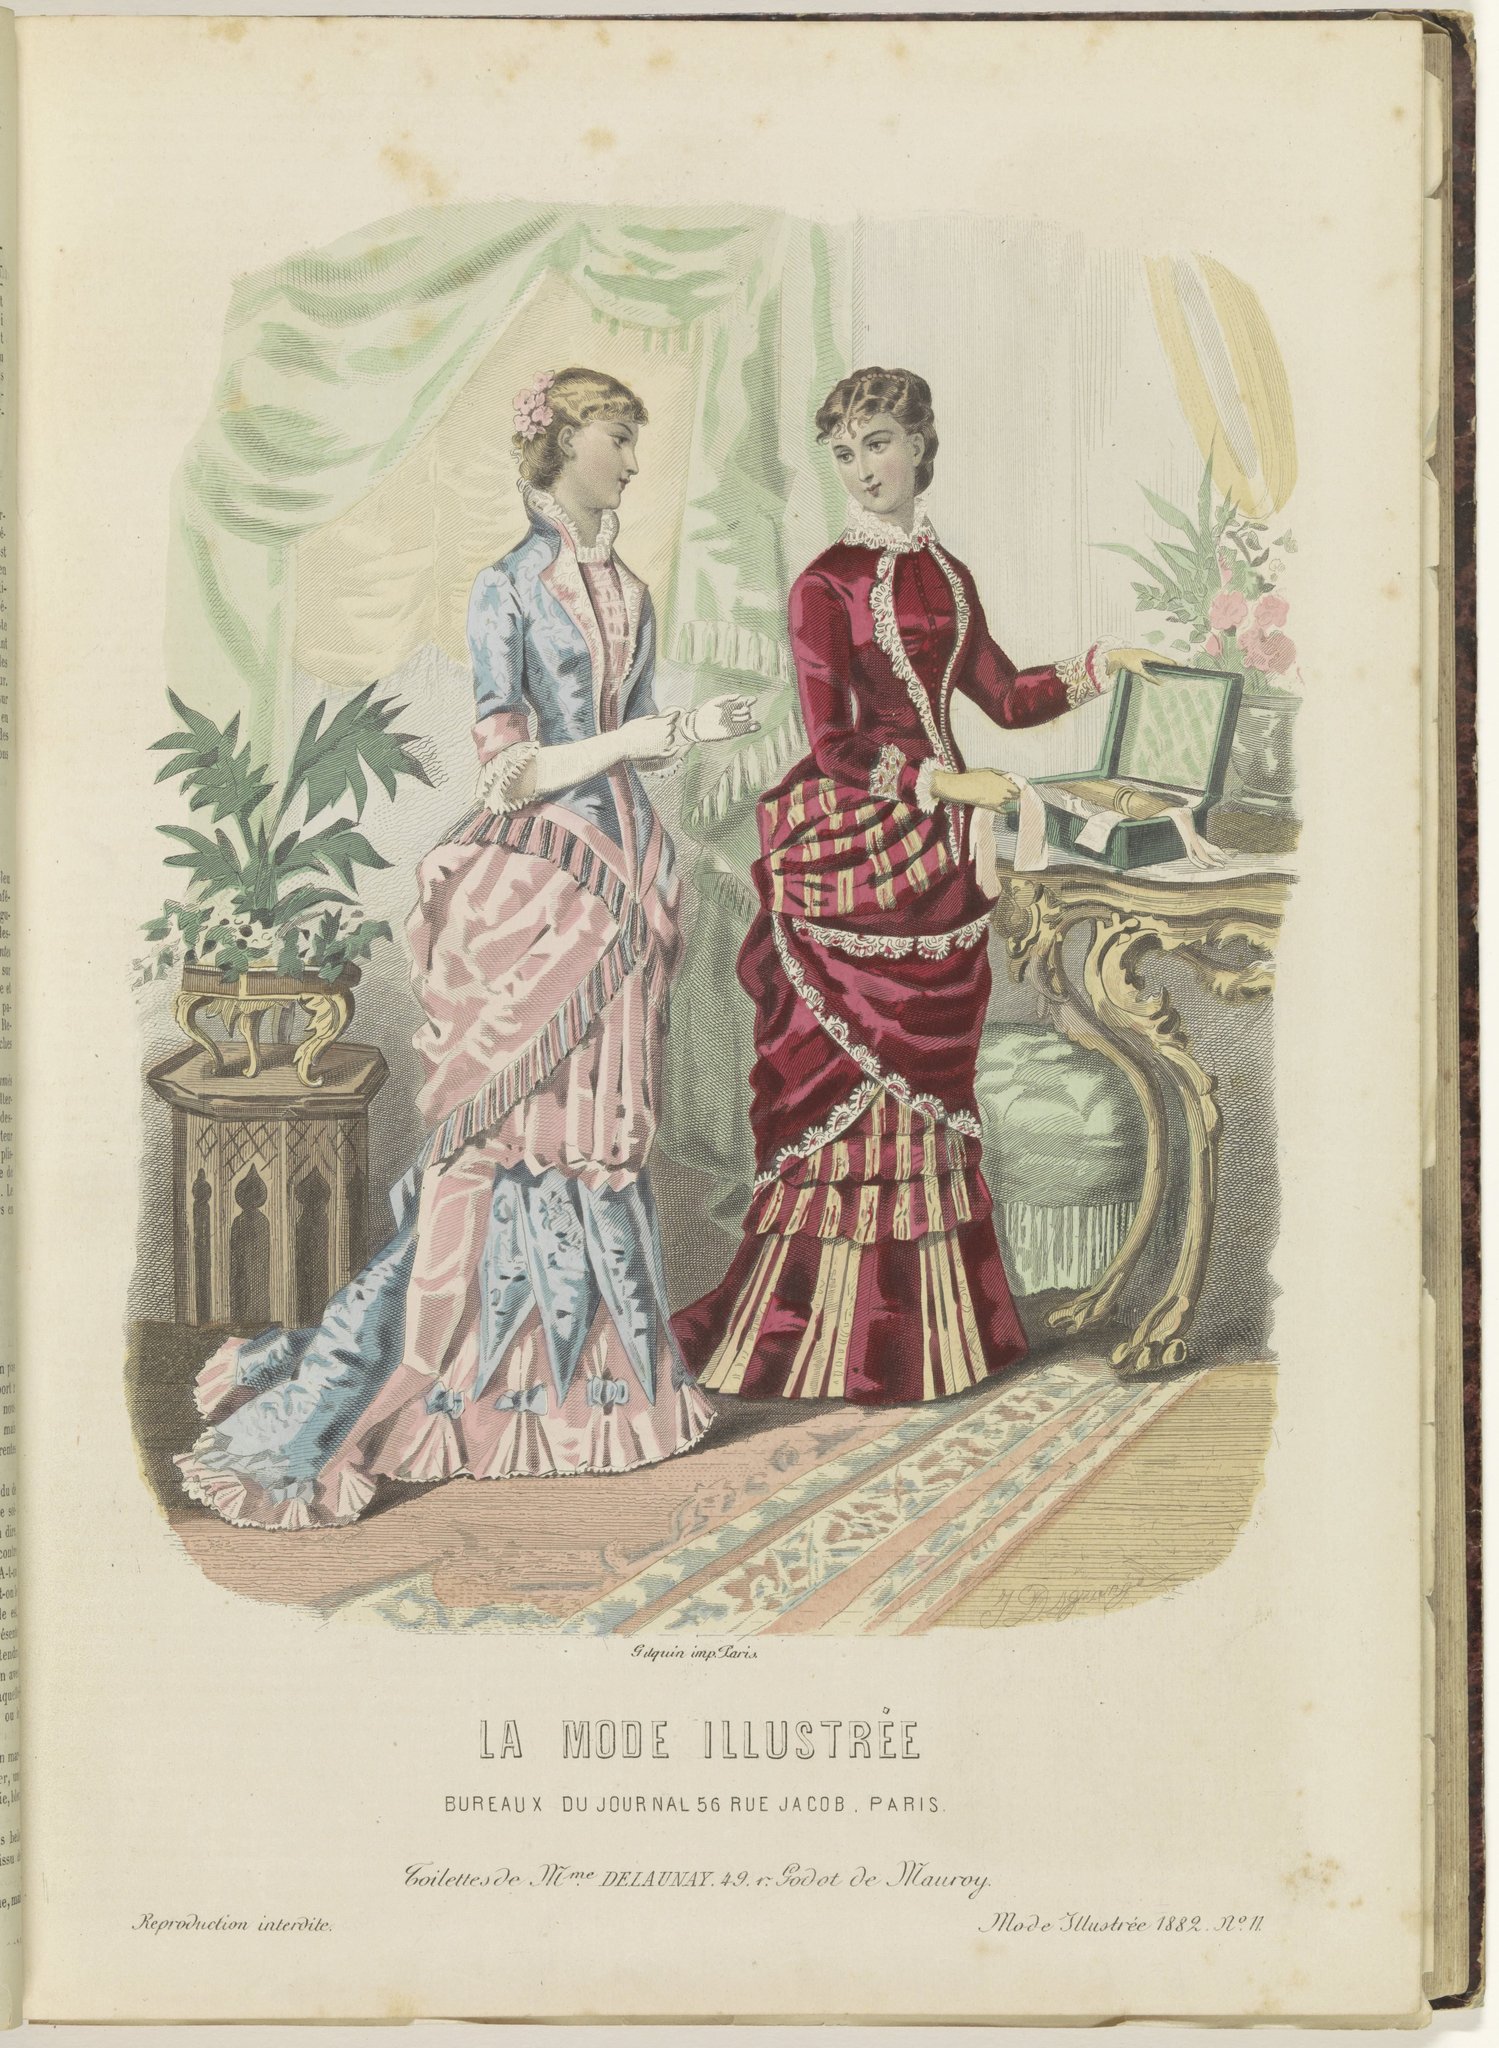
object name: magazine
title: La Mode Illustrée, Journal de la Famille, 1882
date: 1882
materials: paper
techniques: engraving, hand coloring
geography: paris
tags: fashion plates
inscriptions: date